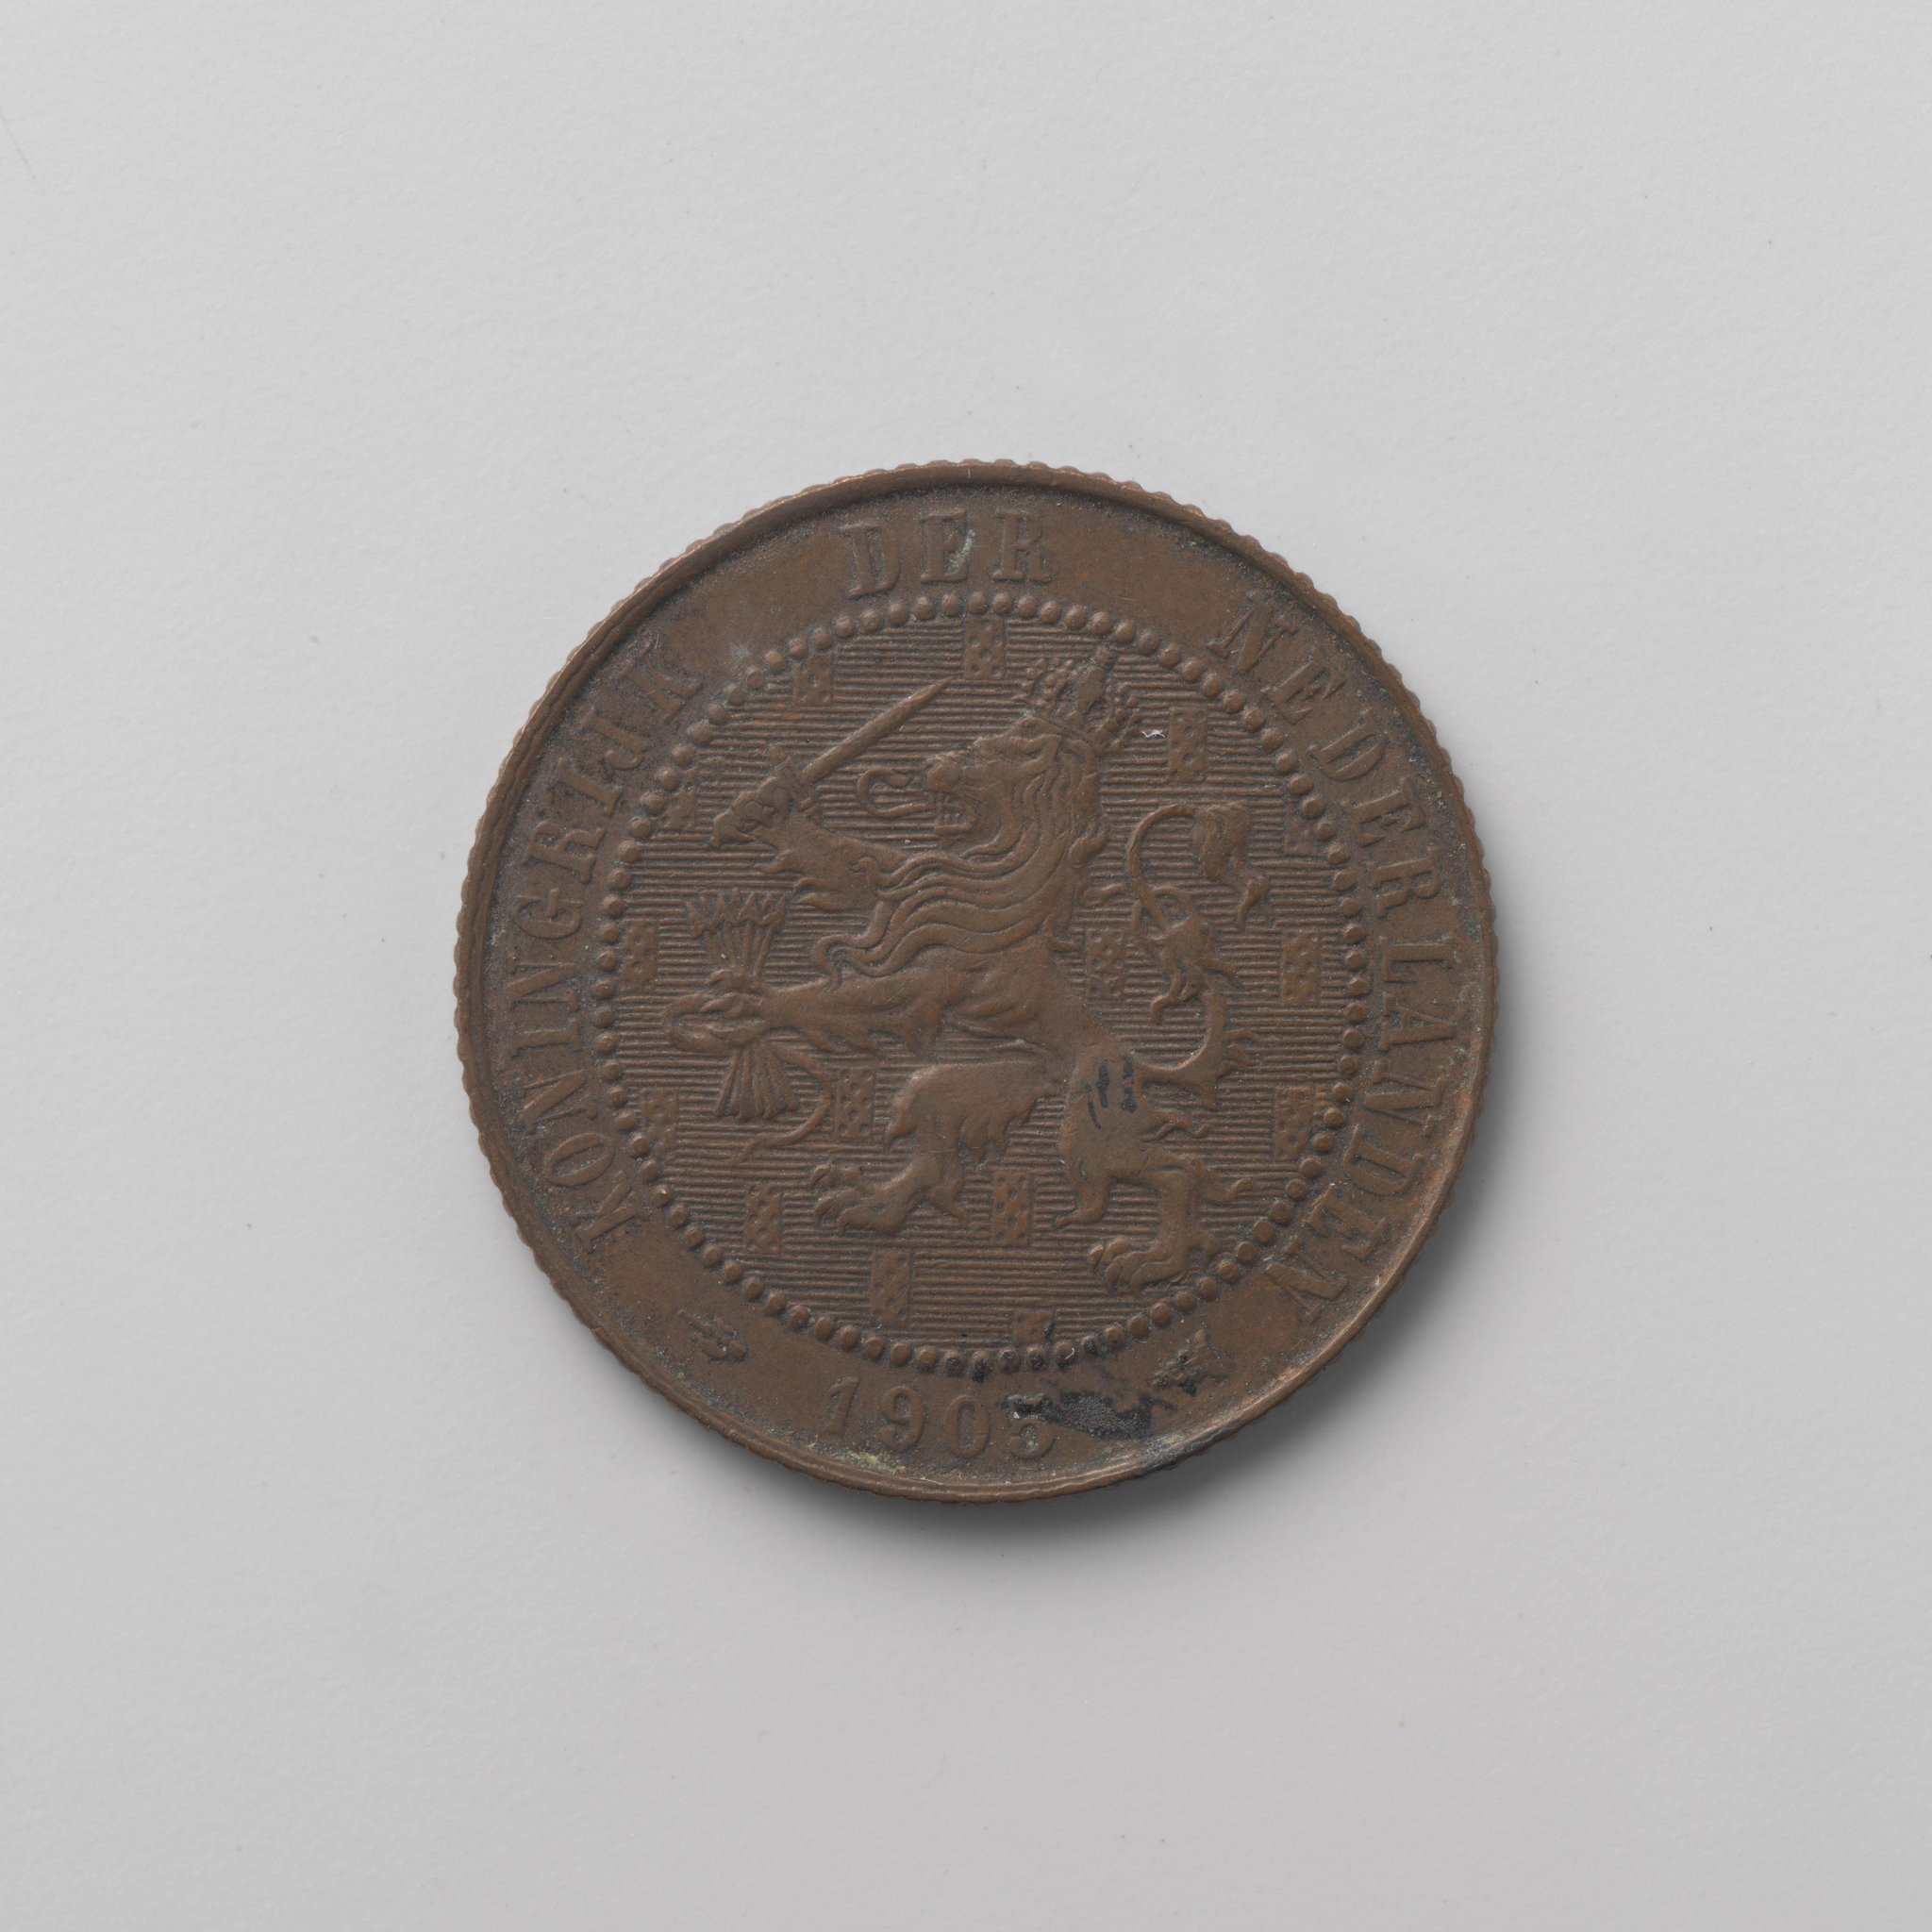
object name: coin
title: Nederlandse 2½ cent,1905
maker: wilhelmina of the netherlands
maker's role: print maker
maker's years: 1880-1962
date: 1905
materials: bronze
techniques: striking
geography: utrecht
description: Bronzen munt. Voorzijde: in een veld rijkswapen. Jaartal onderaan in omschrift.Keerzijde: binnen twee samengebonden oranjetakken waarde-aanduiding 2½ cent. Kartelrand.